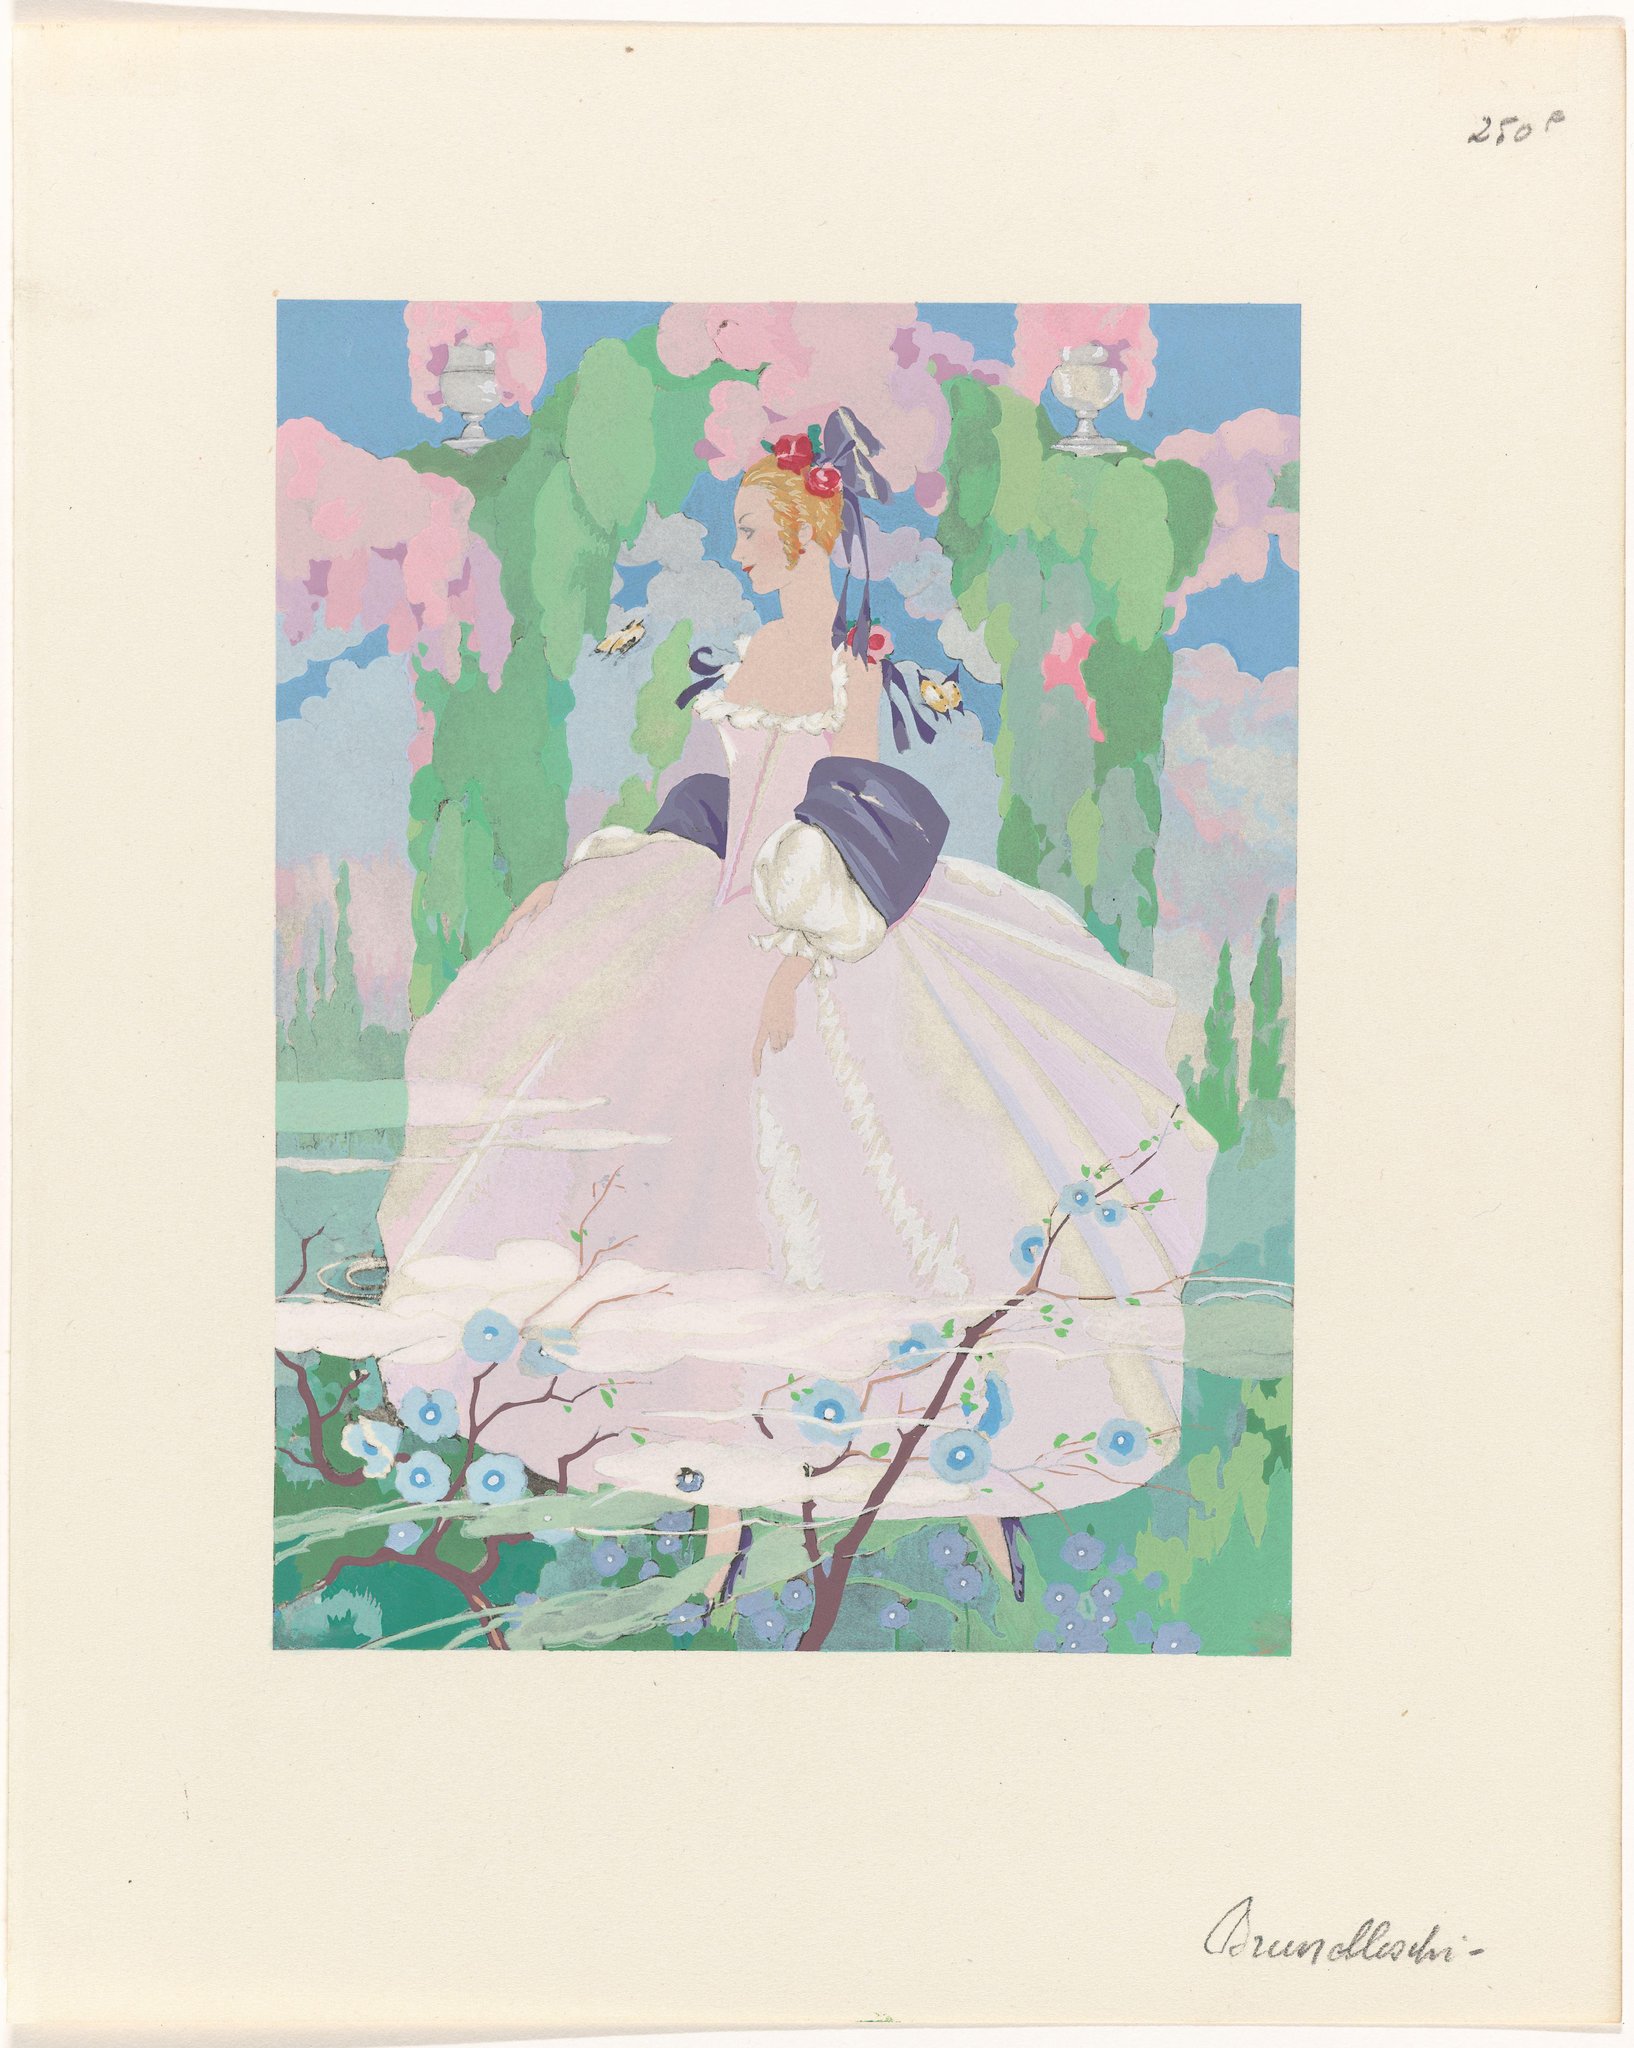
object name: drawing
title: La Guirlande, Album mensuel d'art et de la litterature, 1919-1920 : Vrouw in roze jurk in tuin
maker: umberto brunelleschi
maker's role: designer, draughtsman, painter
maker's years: 1879-1949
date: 1919-1920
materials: paper, pencil, watercolor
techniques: hand coloring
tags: flowers, garden, fashion plates, dress, gown (+ women's clothes), insects: butterfly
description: Een vrouw wandelt in een tuin met vlinders. Zij draagt een roze japon met vierkante hals en wijde rok. De ontwerptekening is waarschijnlijk gemaakt voor het tijdschrift La Guirlande, Album mensuel d'art et de la litterature (1919-1920).